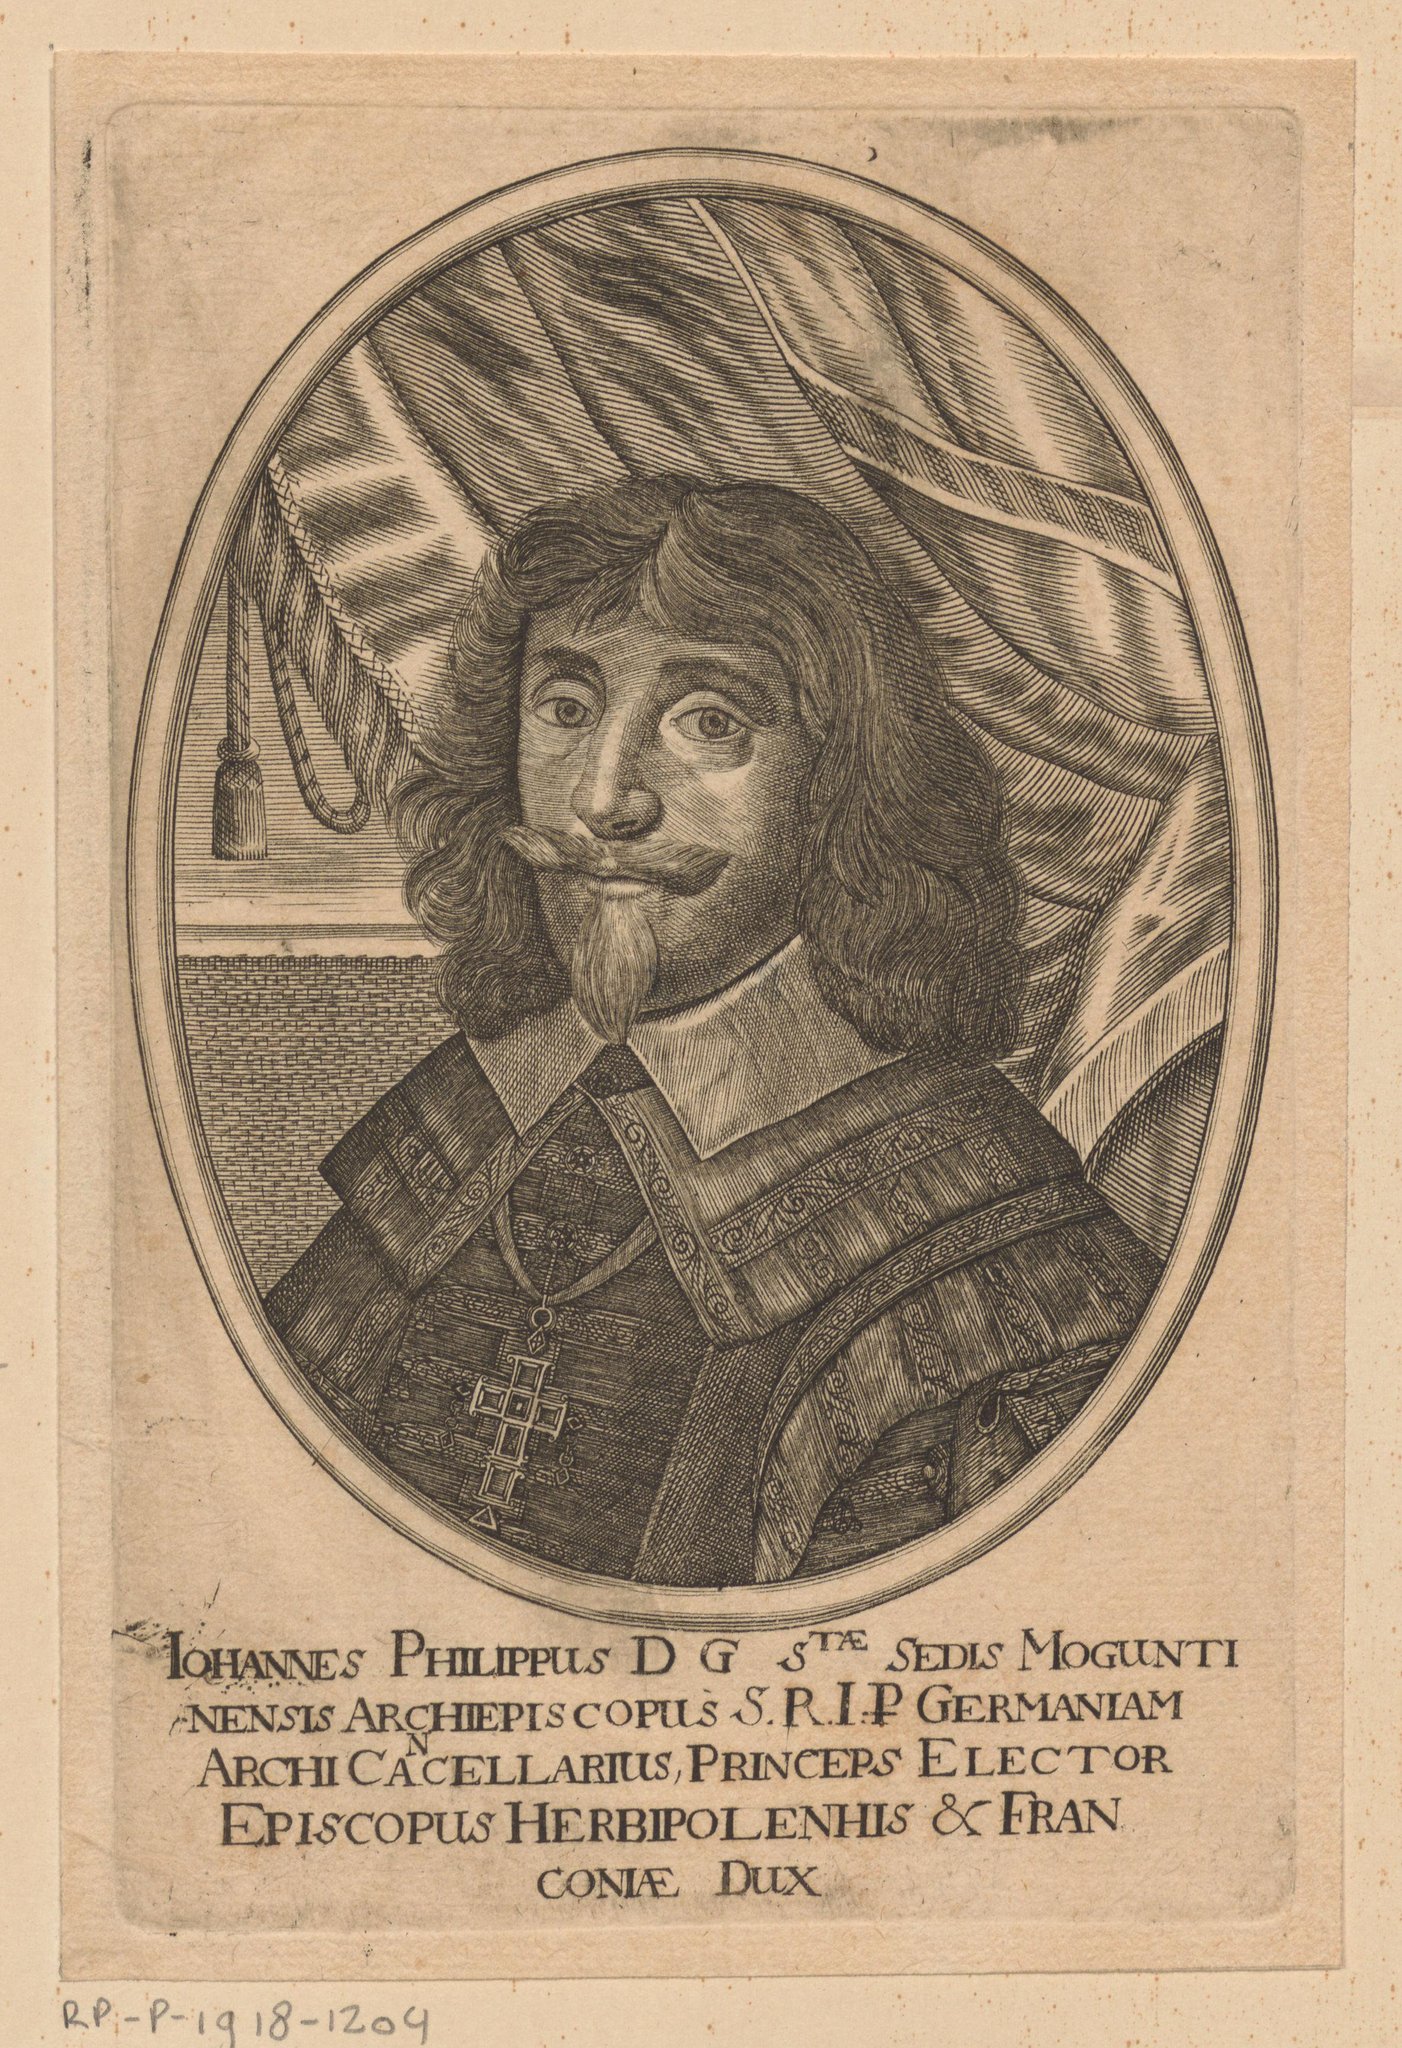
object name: print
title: Portret van Johann Philipp von Schönborn, aartsbisschop van Mainz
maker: Anonymous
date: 1648-1699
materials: paper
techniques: engraving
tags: archbishop, bishop, etc. (roman catholic), historical persons